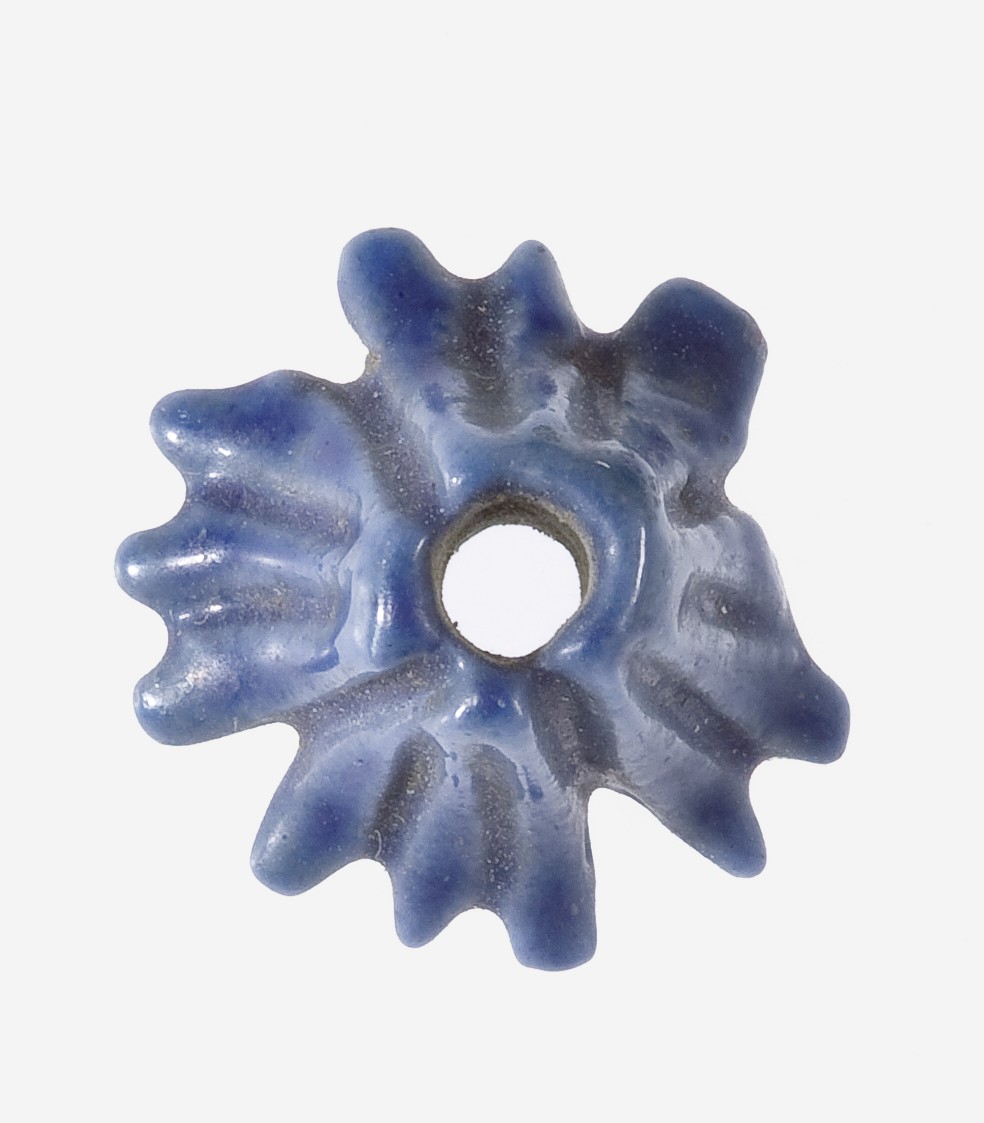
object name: pendant, cornflower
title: Pendant: Petals of Cornflower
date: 1390-1352 BCE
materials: faience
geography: egypt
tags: flowers